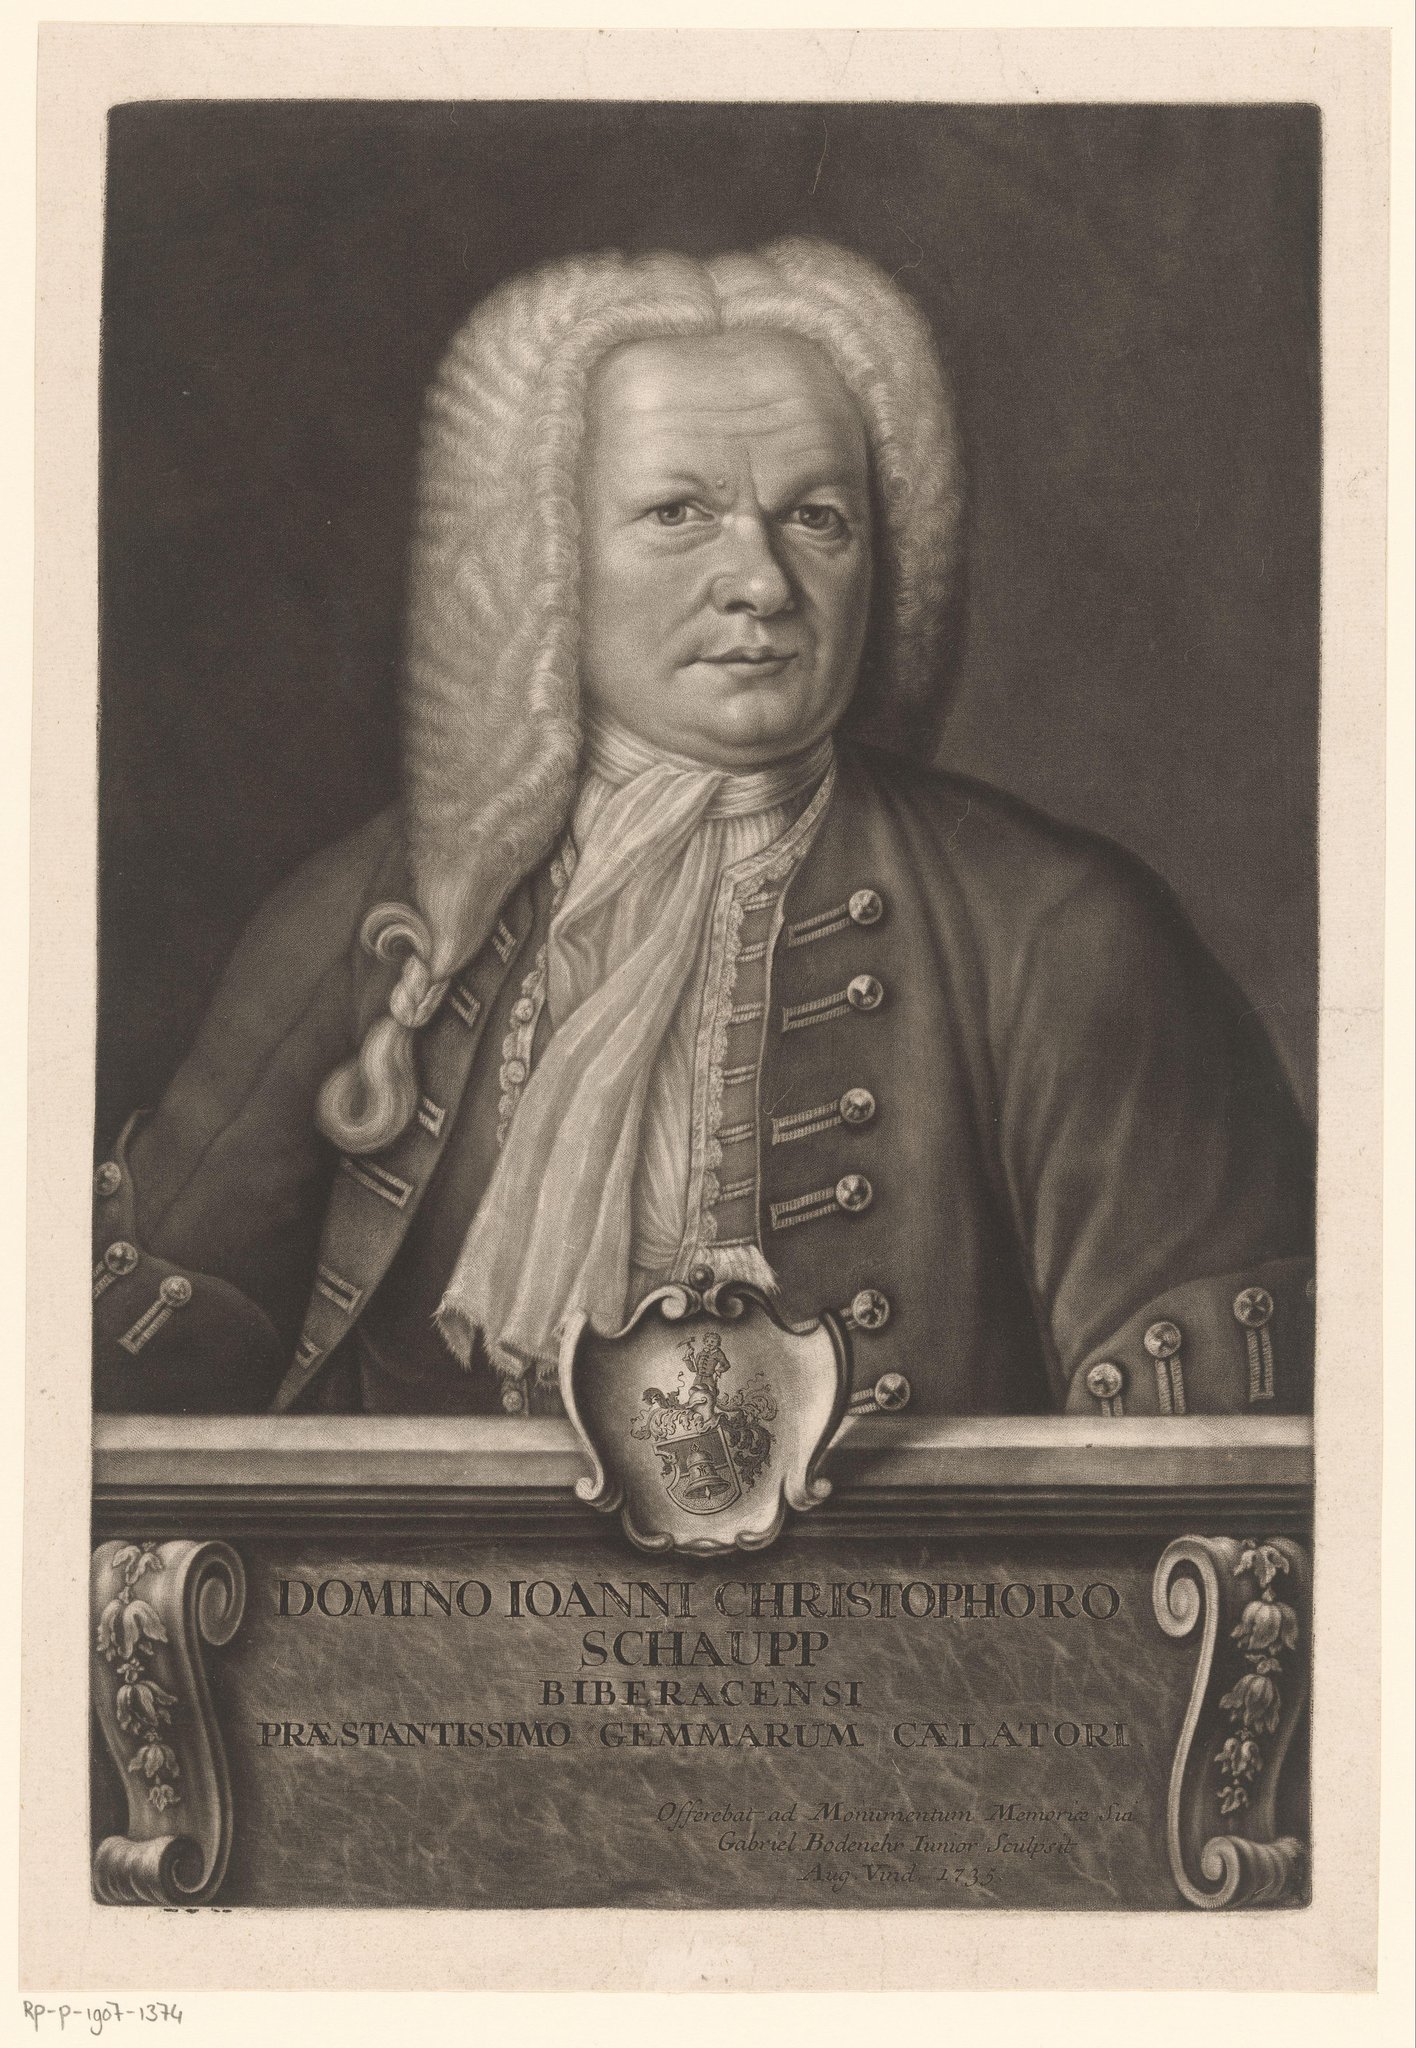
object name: print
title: Portret van Johann Christoph Schaupp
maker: gabriel bodenehr (ii)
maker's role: print maker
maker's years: 1705-1792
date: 1735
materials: paper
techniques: engraving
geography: augsburg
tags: jeweler, historical persons, jeweller, goldsmith, silversmith, armorial bearing, heraldry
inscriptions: collector's mark: Lugt 2228